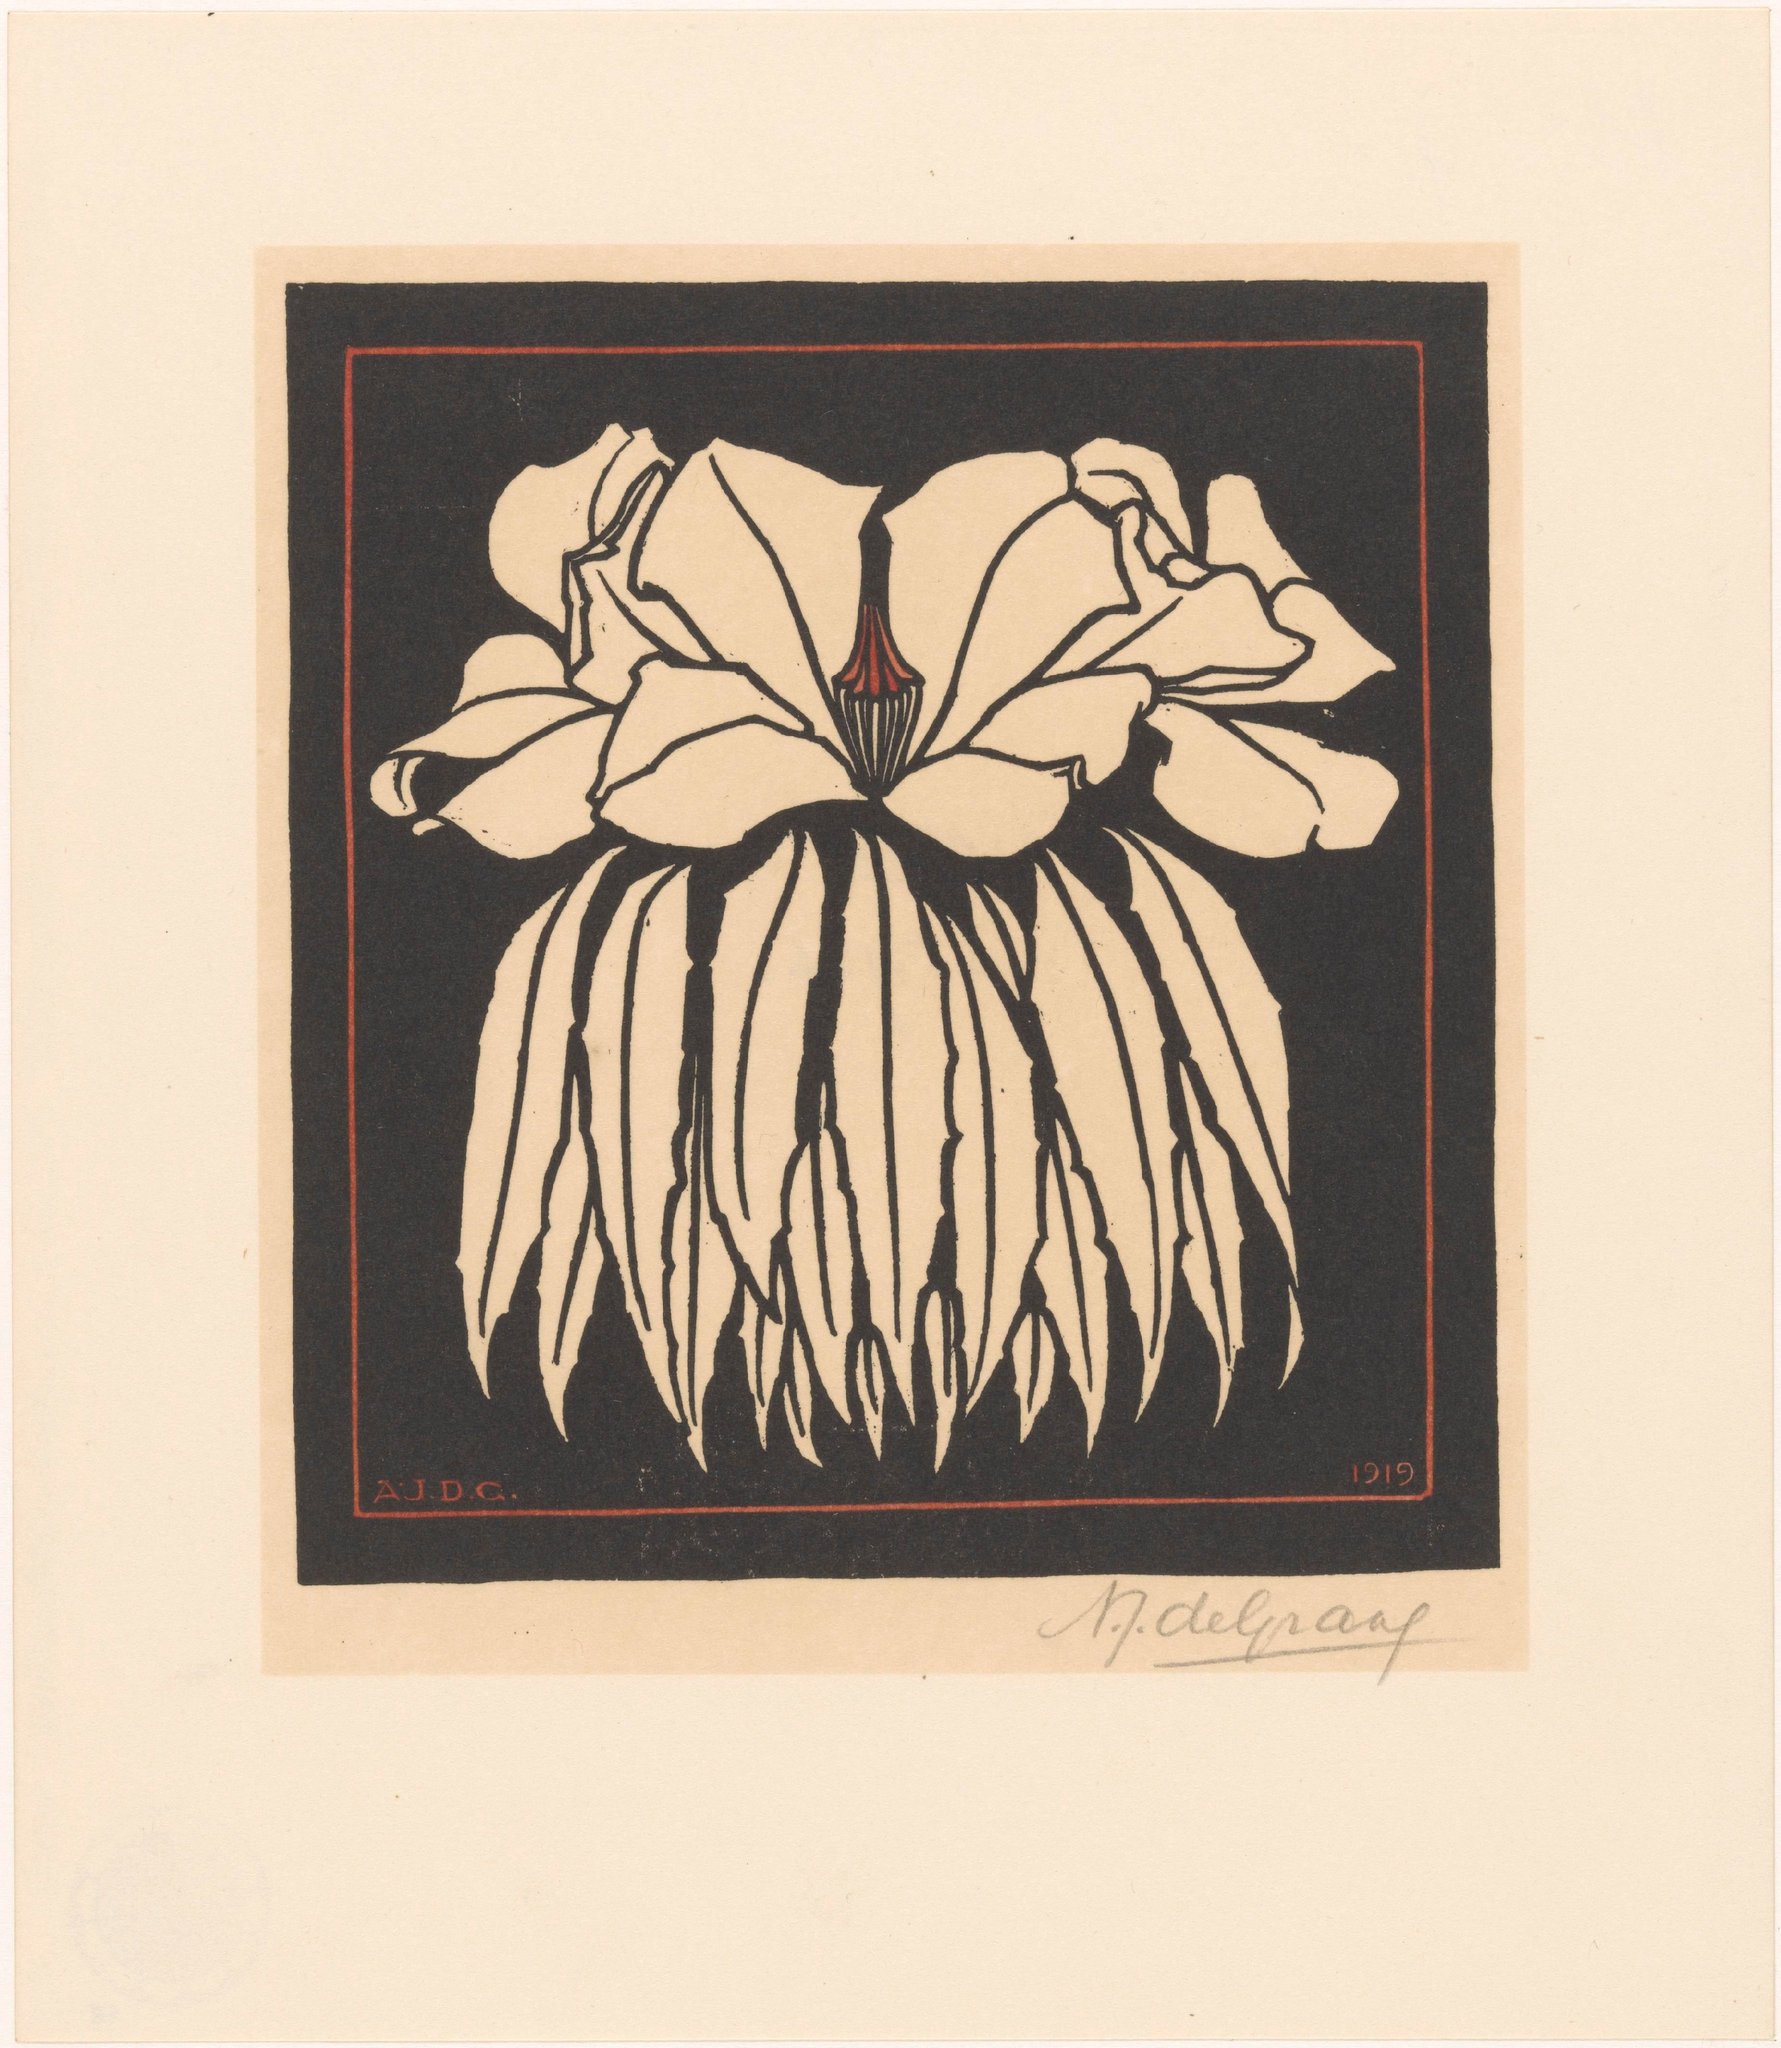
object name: print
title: Godetia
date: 1919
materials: paper, watercolor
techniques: hand coloring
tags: flowers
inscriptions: collector's mark: Lugt 2228